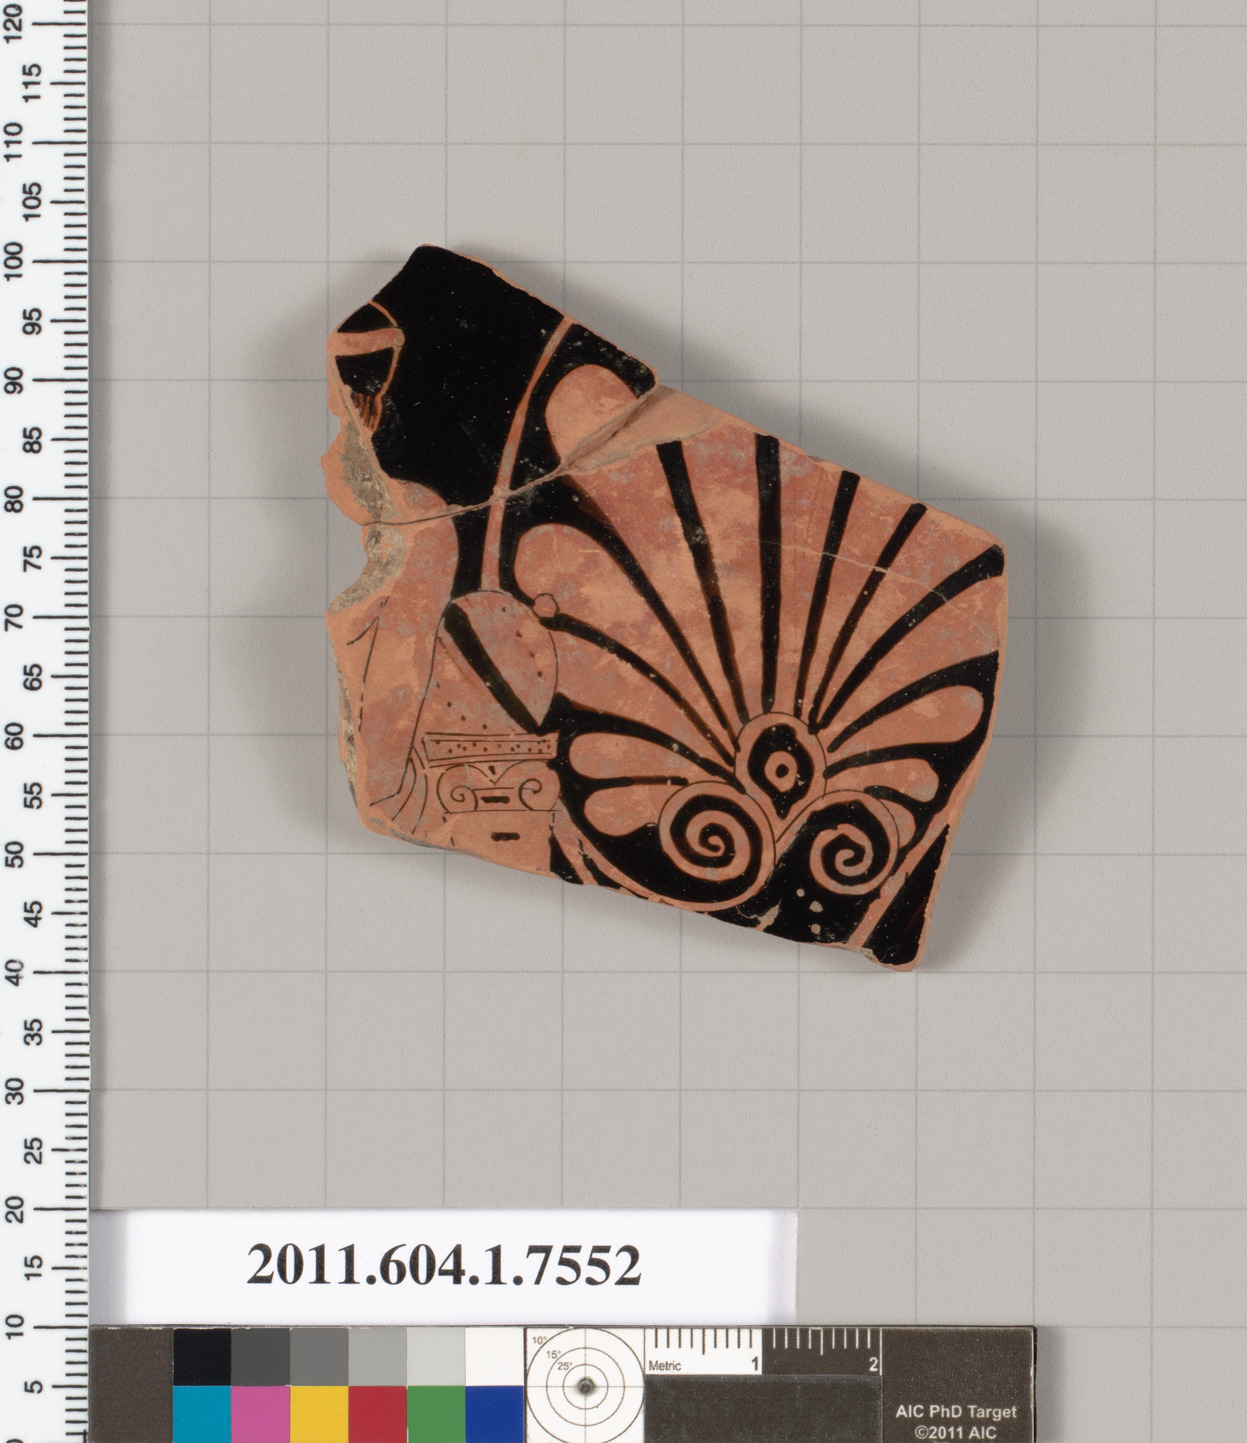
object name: kylix fragment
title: Terracotta fragment of a kylix (drinking cup)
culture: greek, attic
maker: euaion painter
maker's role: artist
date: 460-450 BCE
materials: terracotta